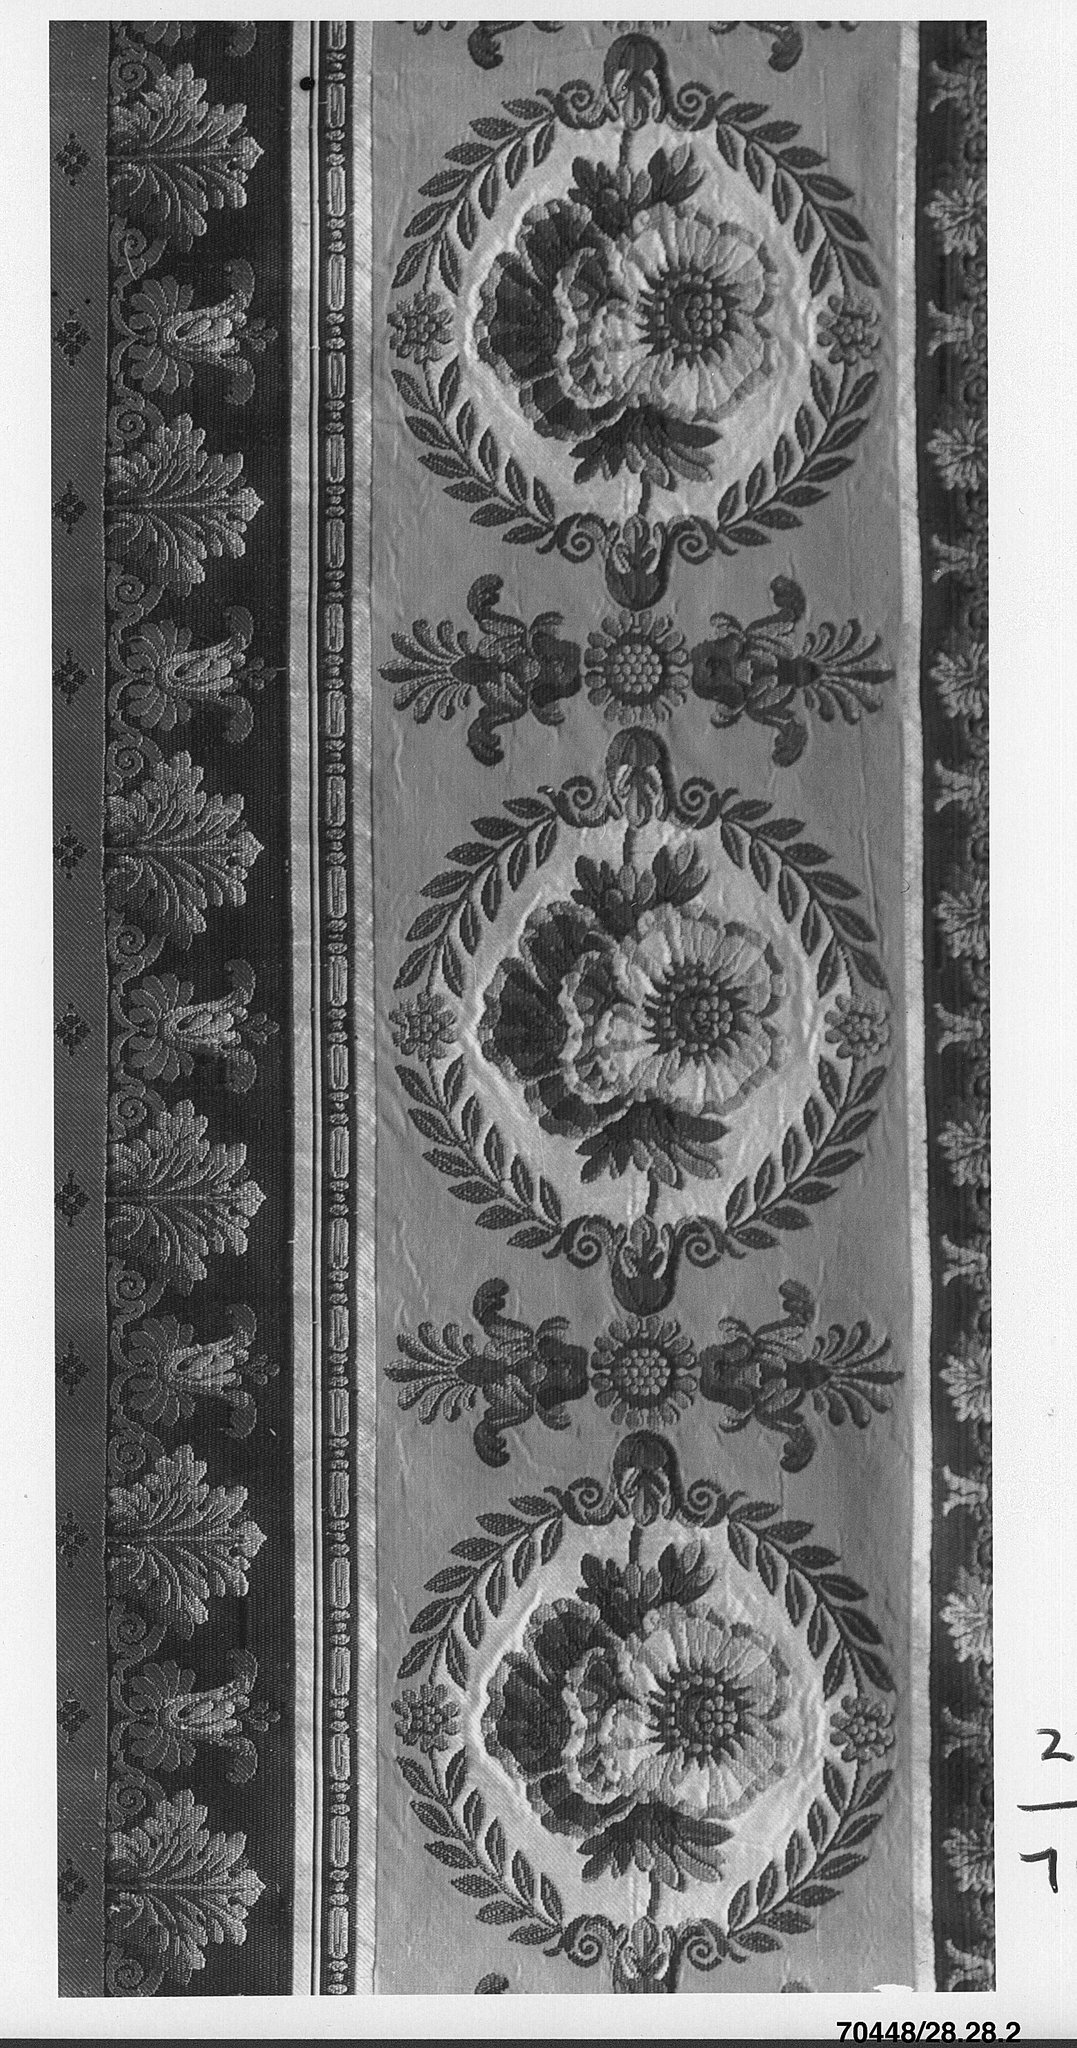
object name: wall fabric border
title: Border for wall fabric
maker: séguin et cie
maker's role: manufactory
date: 1813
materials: metal thread, silk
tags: flowers